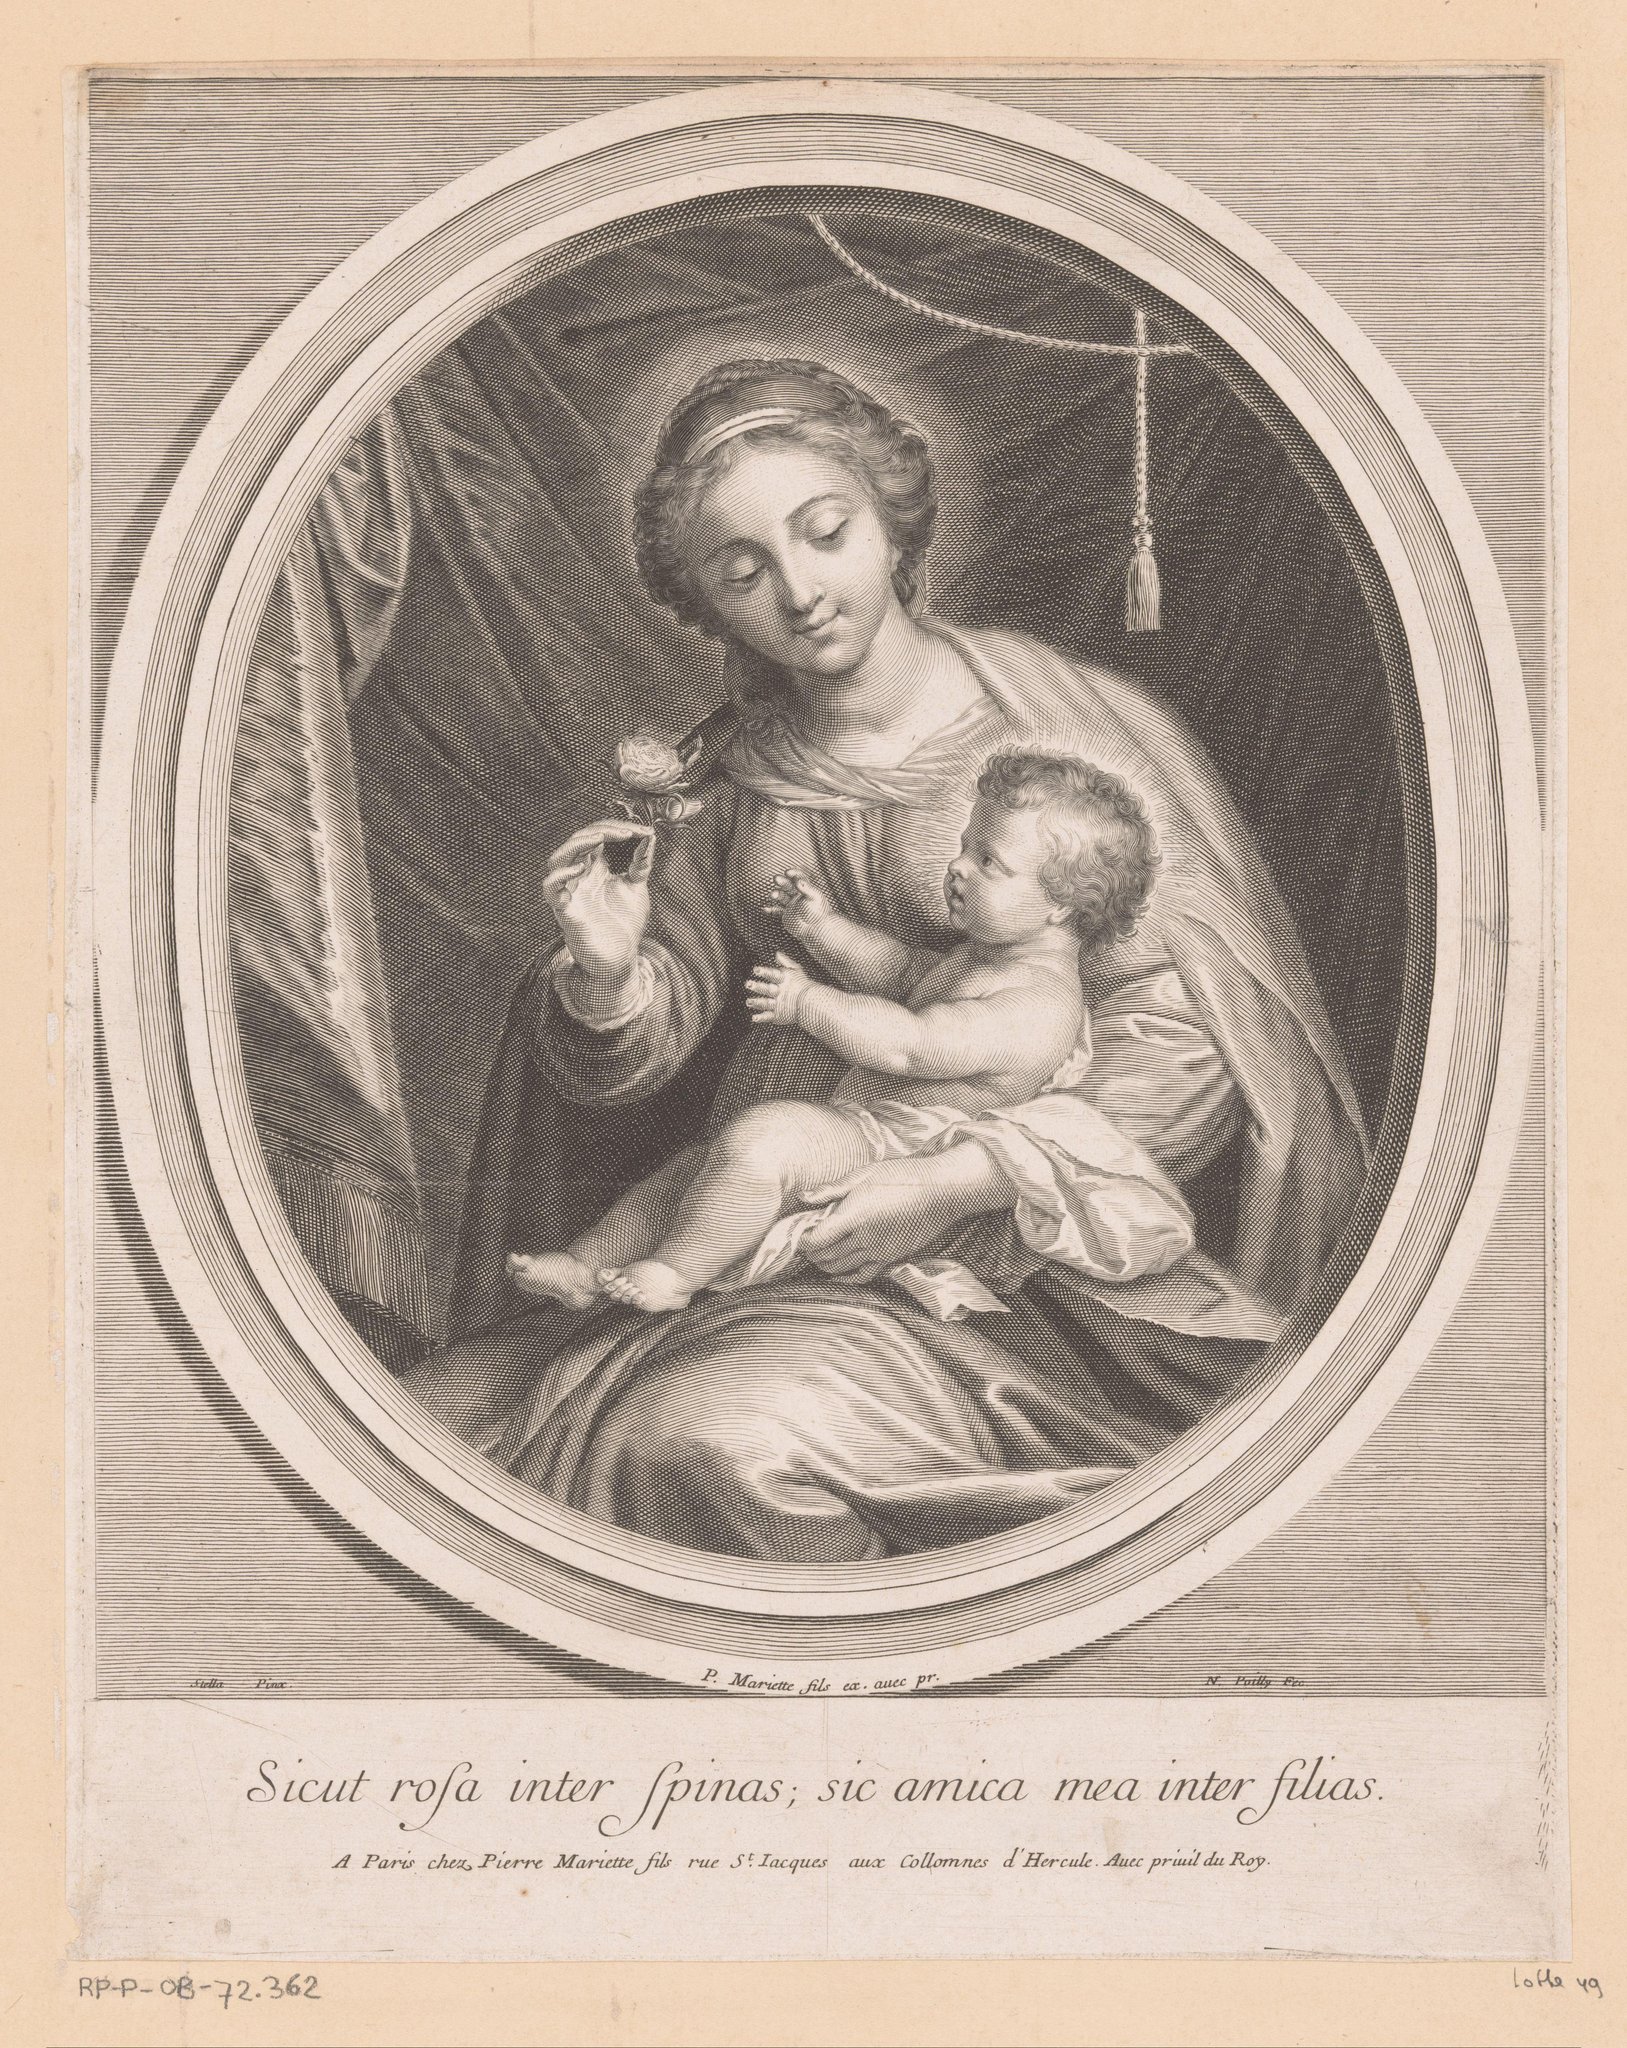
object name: print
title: Maria met kind en roos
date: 1644-1696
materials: paper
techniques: engraving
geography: paris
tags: madonna: i.e. mary with the christ-child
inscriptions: collector's mark: Lugt 240